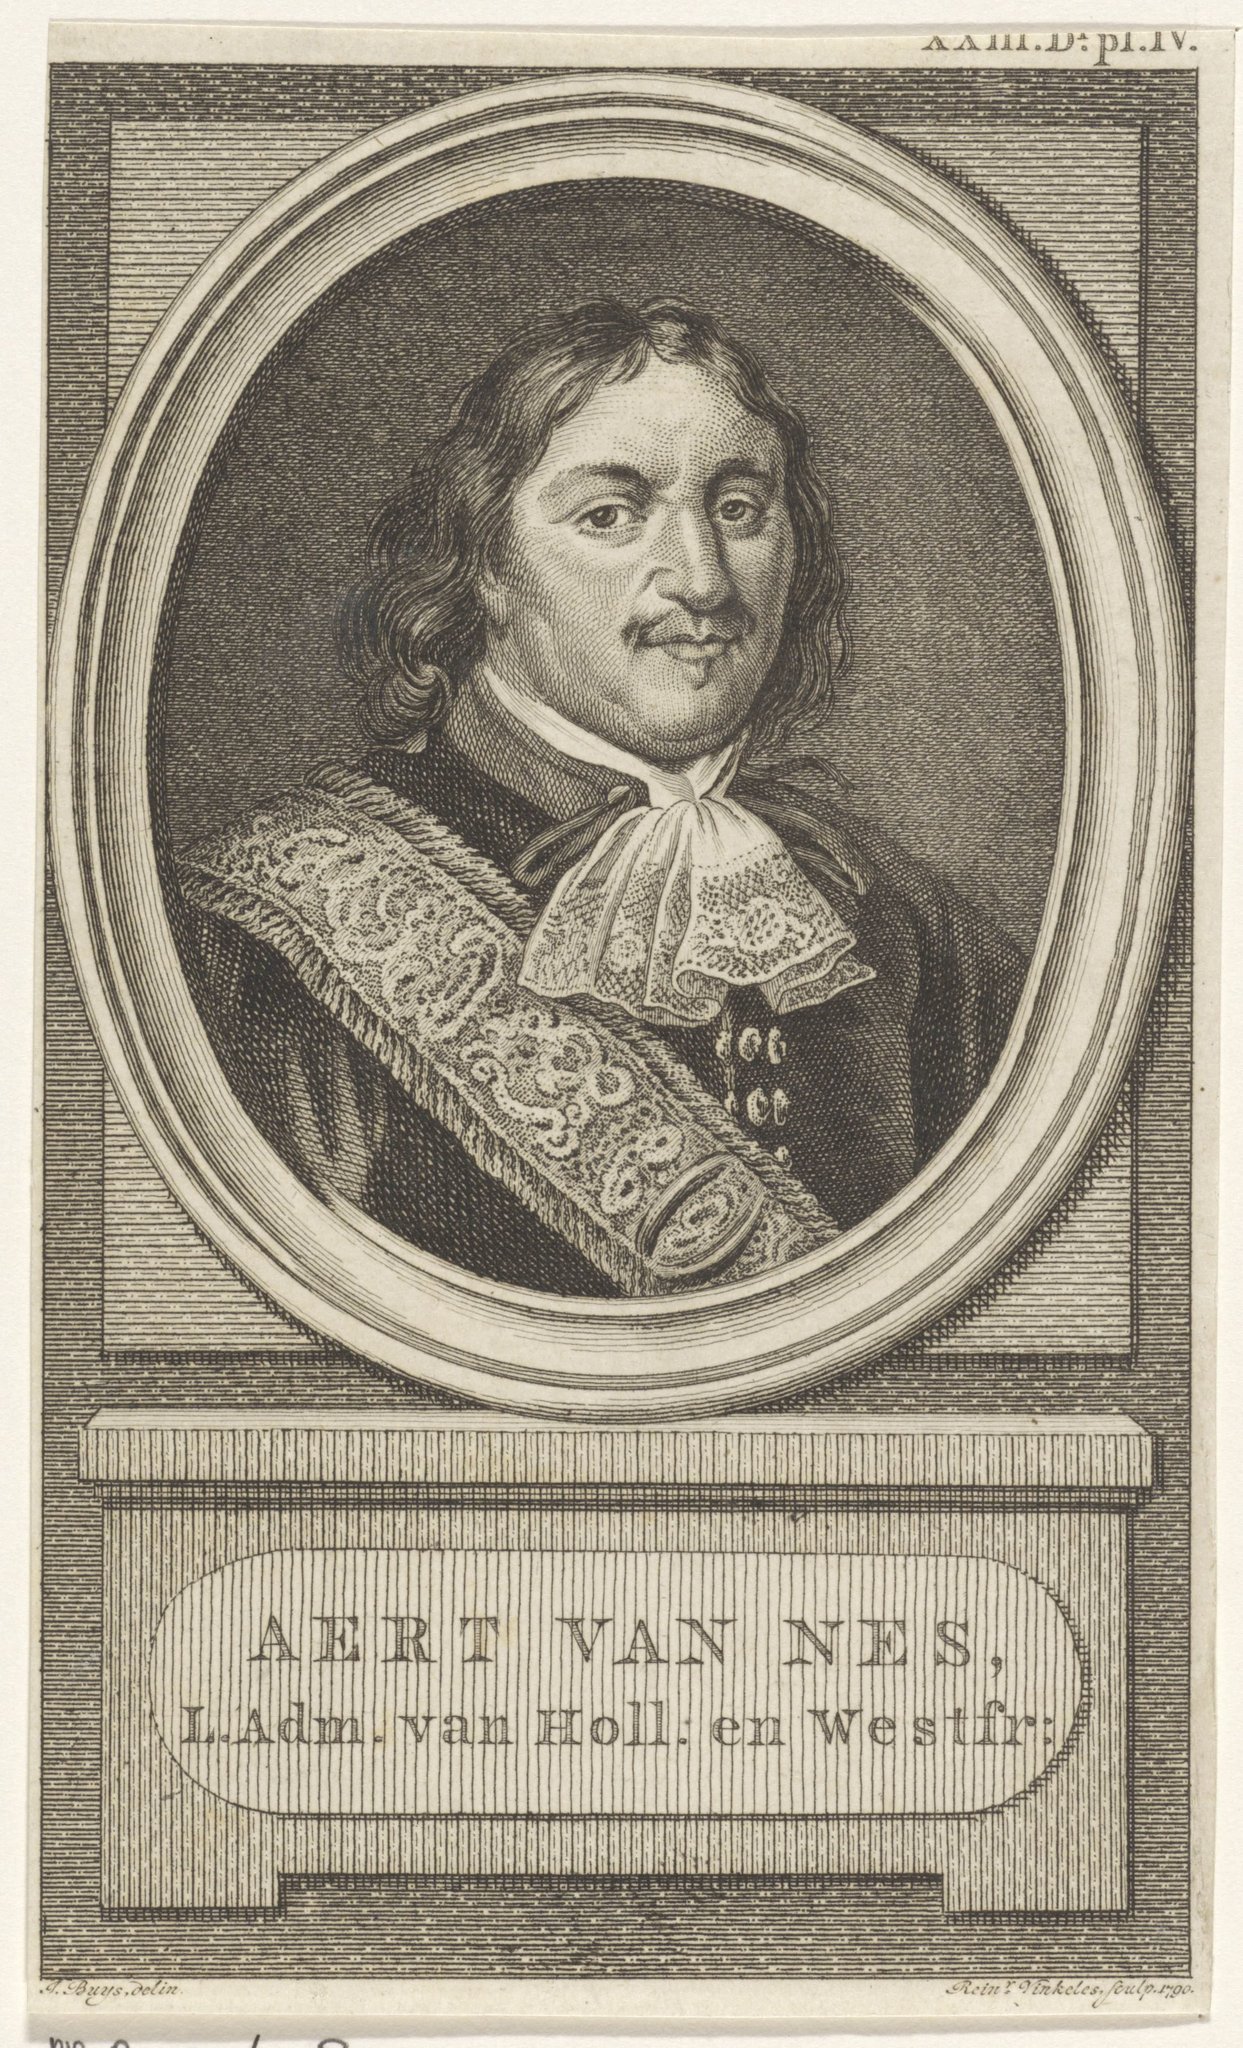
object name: print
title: Portret van Aert Jansz. van Nes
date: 1790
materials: paper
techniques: engraving, etching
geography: amsterdam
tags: rotterdam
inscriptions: collector's mark: Lugt 2228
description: Prent gebruikt als boekillustratie in: Kok, Jacobus. Vaderlandsch woordenboek : met kaarten, plaaten en pourtraitten. Amsterdam: Johannes Allart, 1785-1796. Deel XXIII.